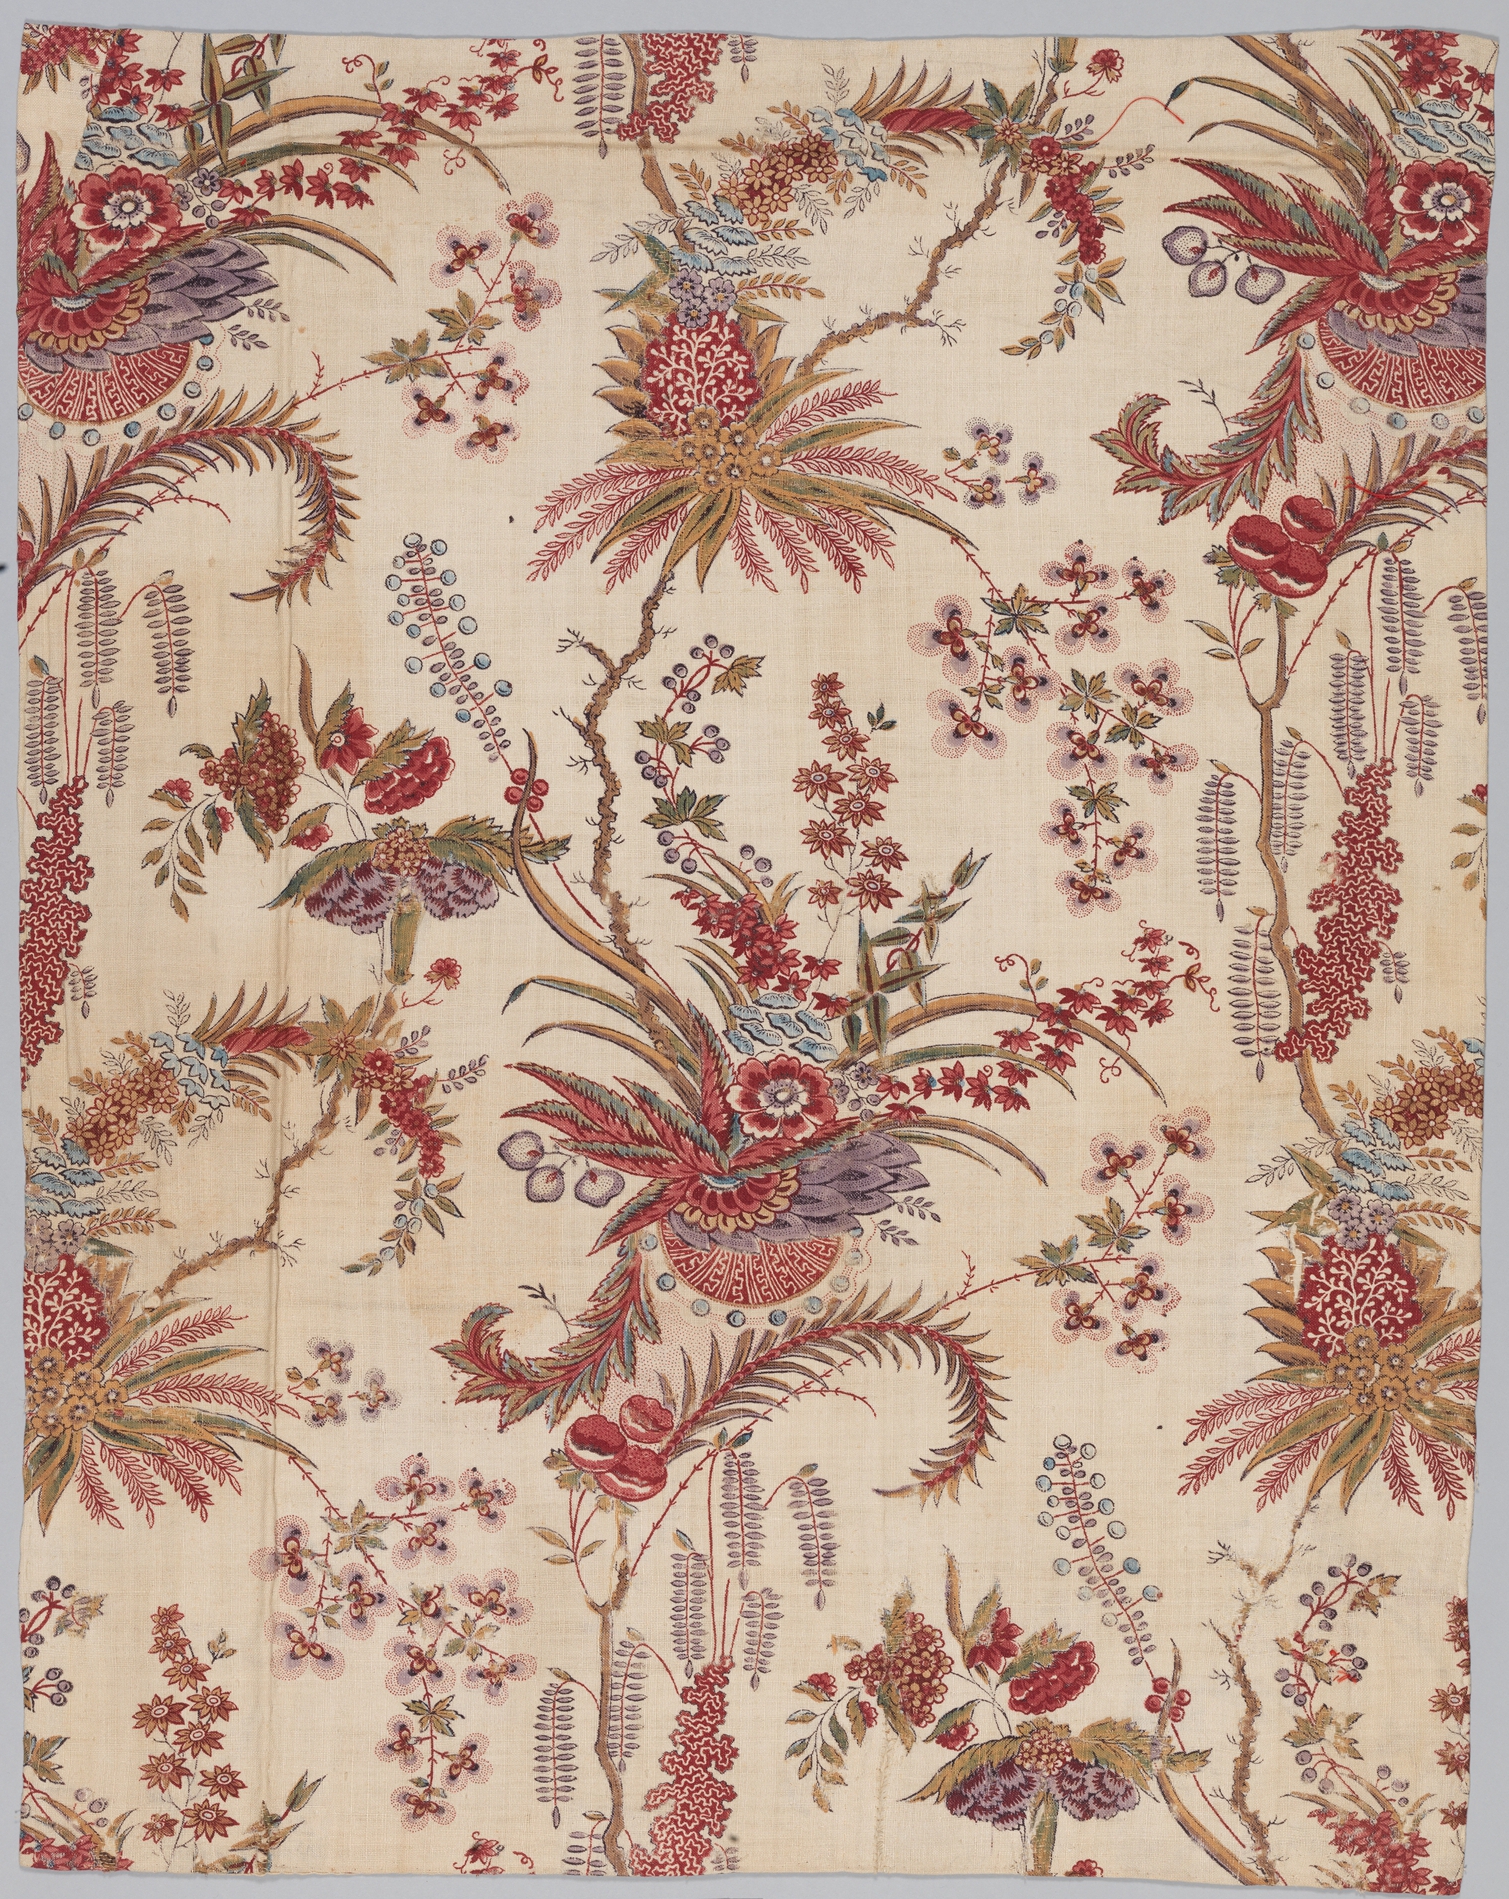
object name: piece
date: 1785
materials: cotton, linen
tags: flowers,leaves